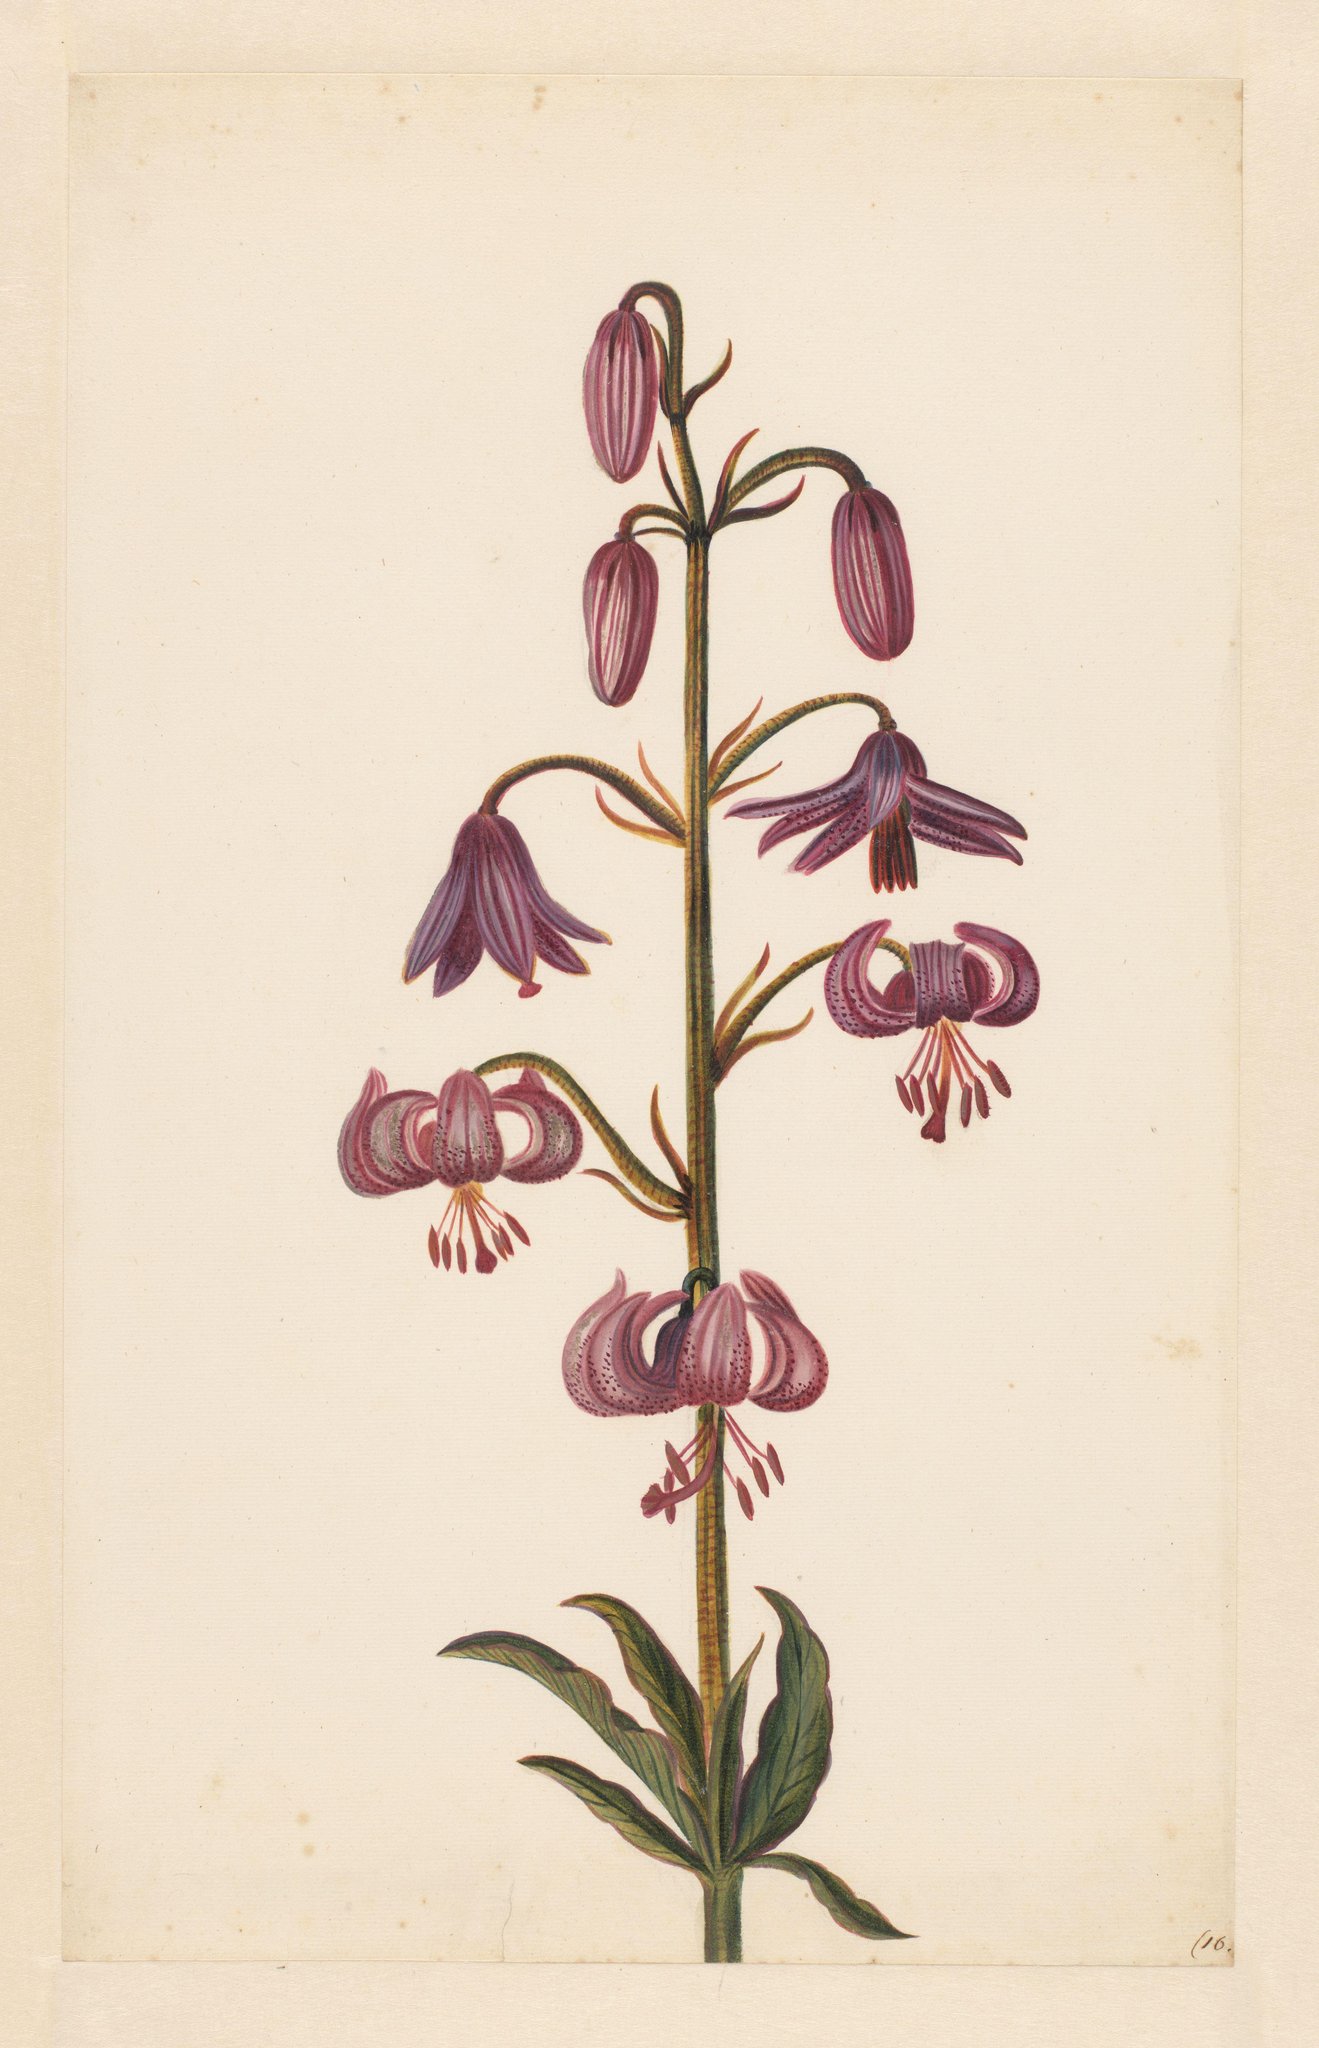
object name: drawing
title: Martagon Lily (Lilium martagon)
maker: alida withoos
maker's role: draughtsman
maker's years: 1659-1730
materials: paper, pencil, watercolor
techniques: brush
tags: flowers: turk's cap lily